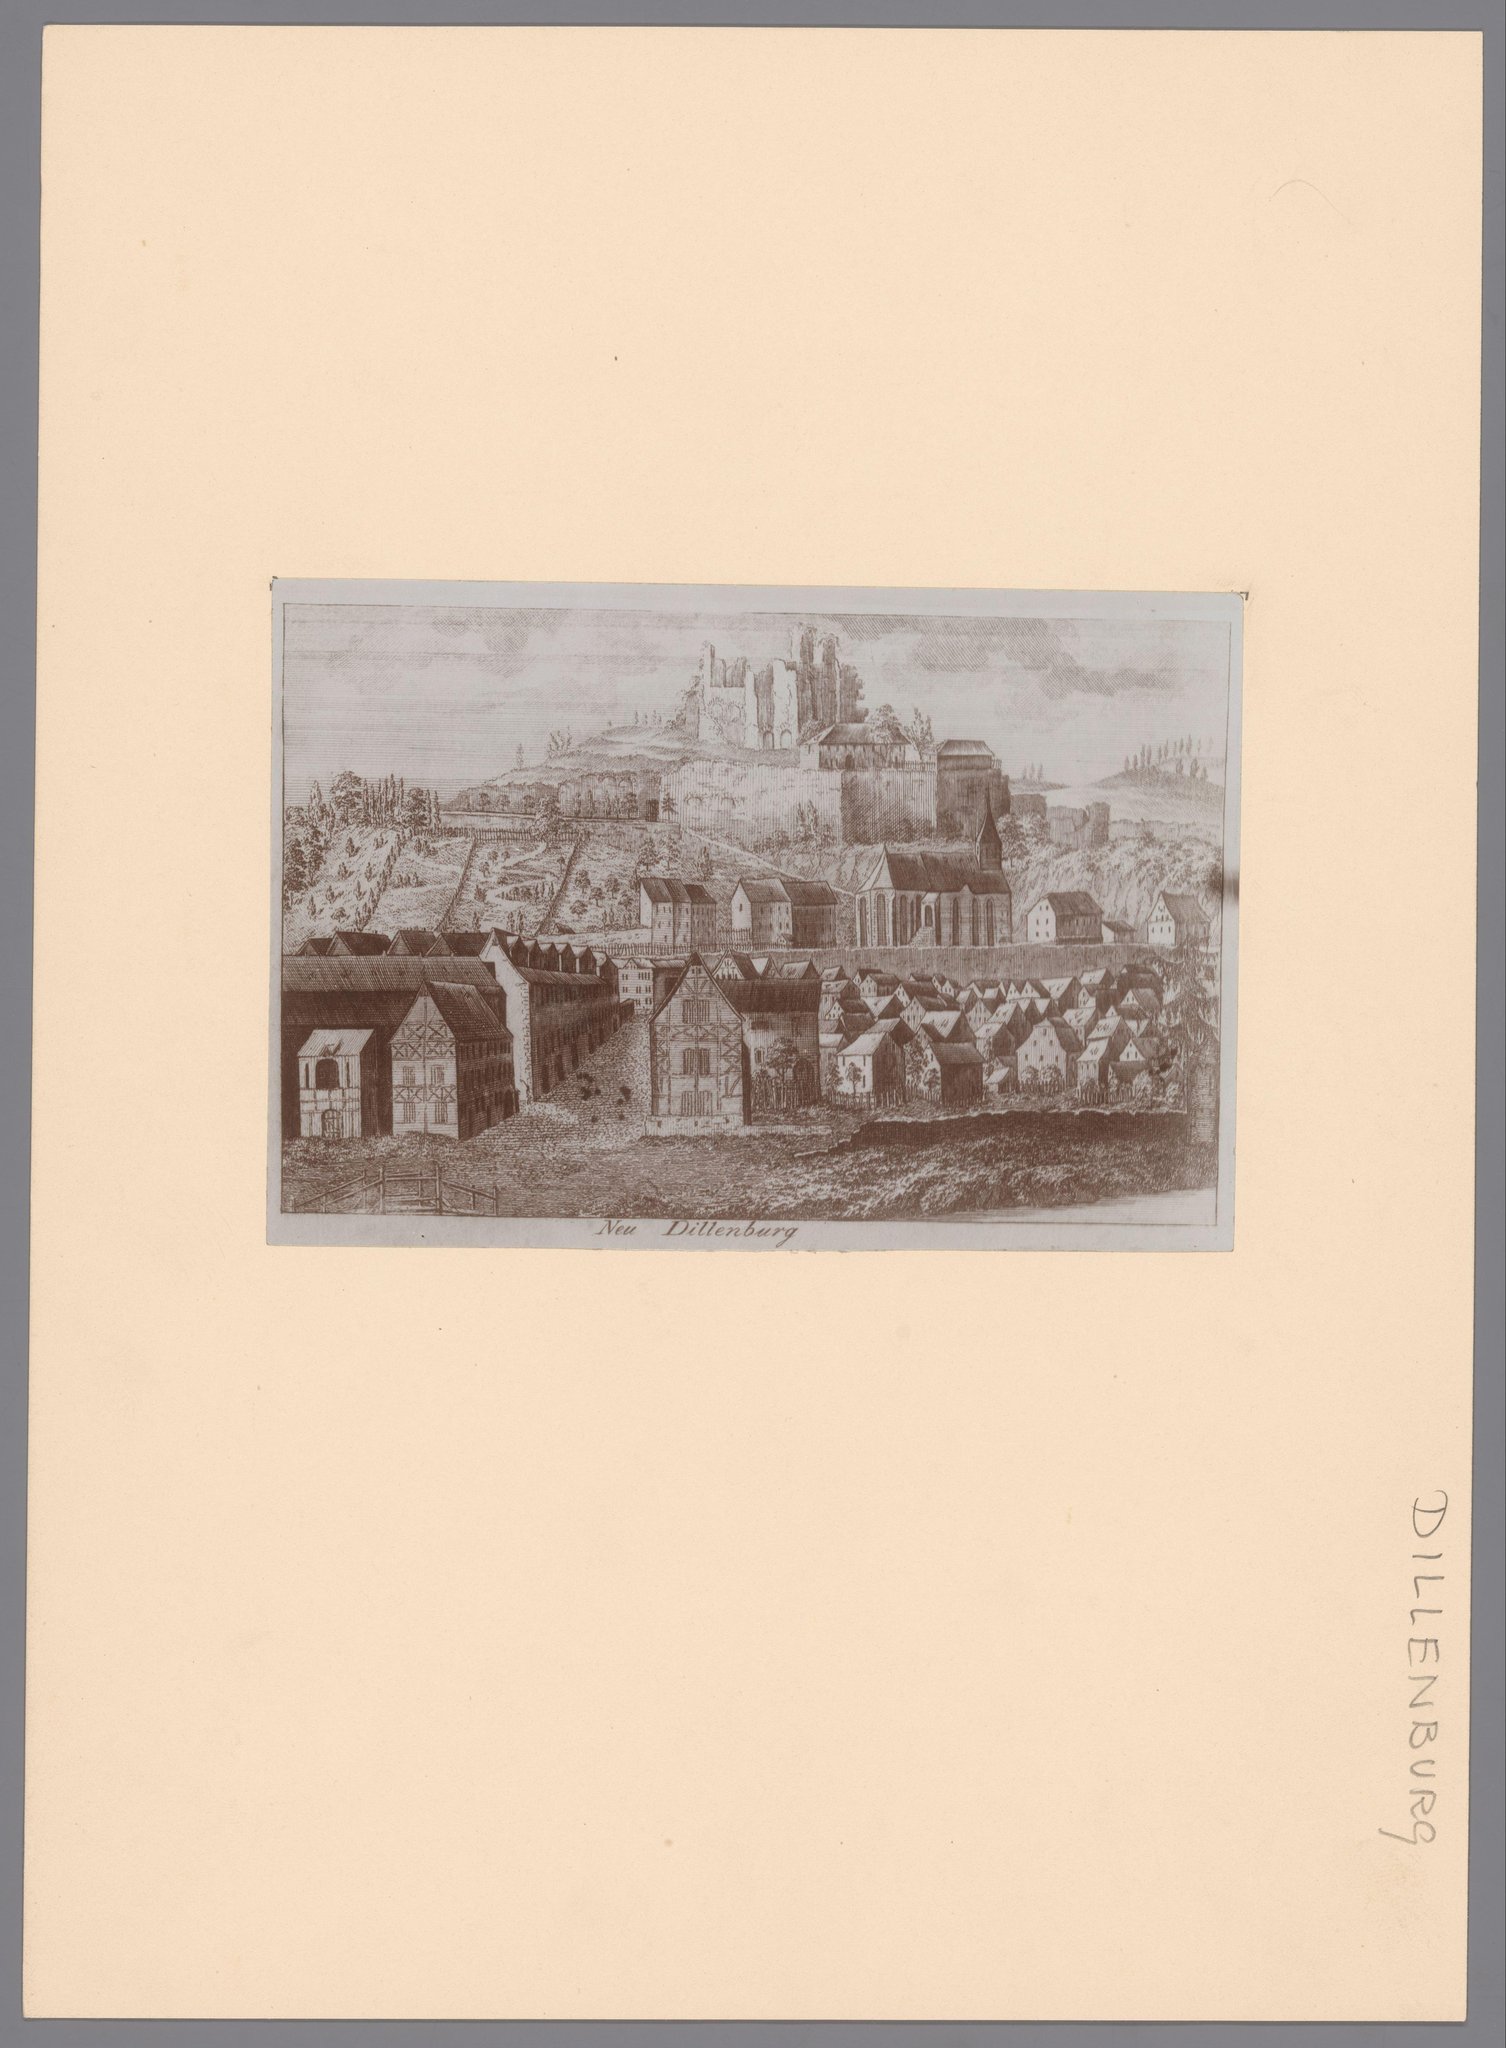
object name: reproduction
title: Fotoreproductie van de prent of pentekening Neu Dillenburg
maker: Anonymous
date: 1890-1920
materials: cardboard, paper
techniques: collodion silver print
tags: drawing, sketch, print, e.g.: engraving, etching, lithograph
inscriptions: inscription: ‘DILLENBURG’